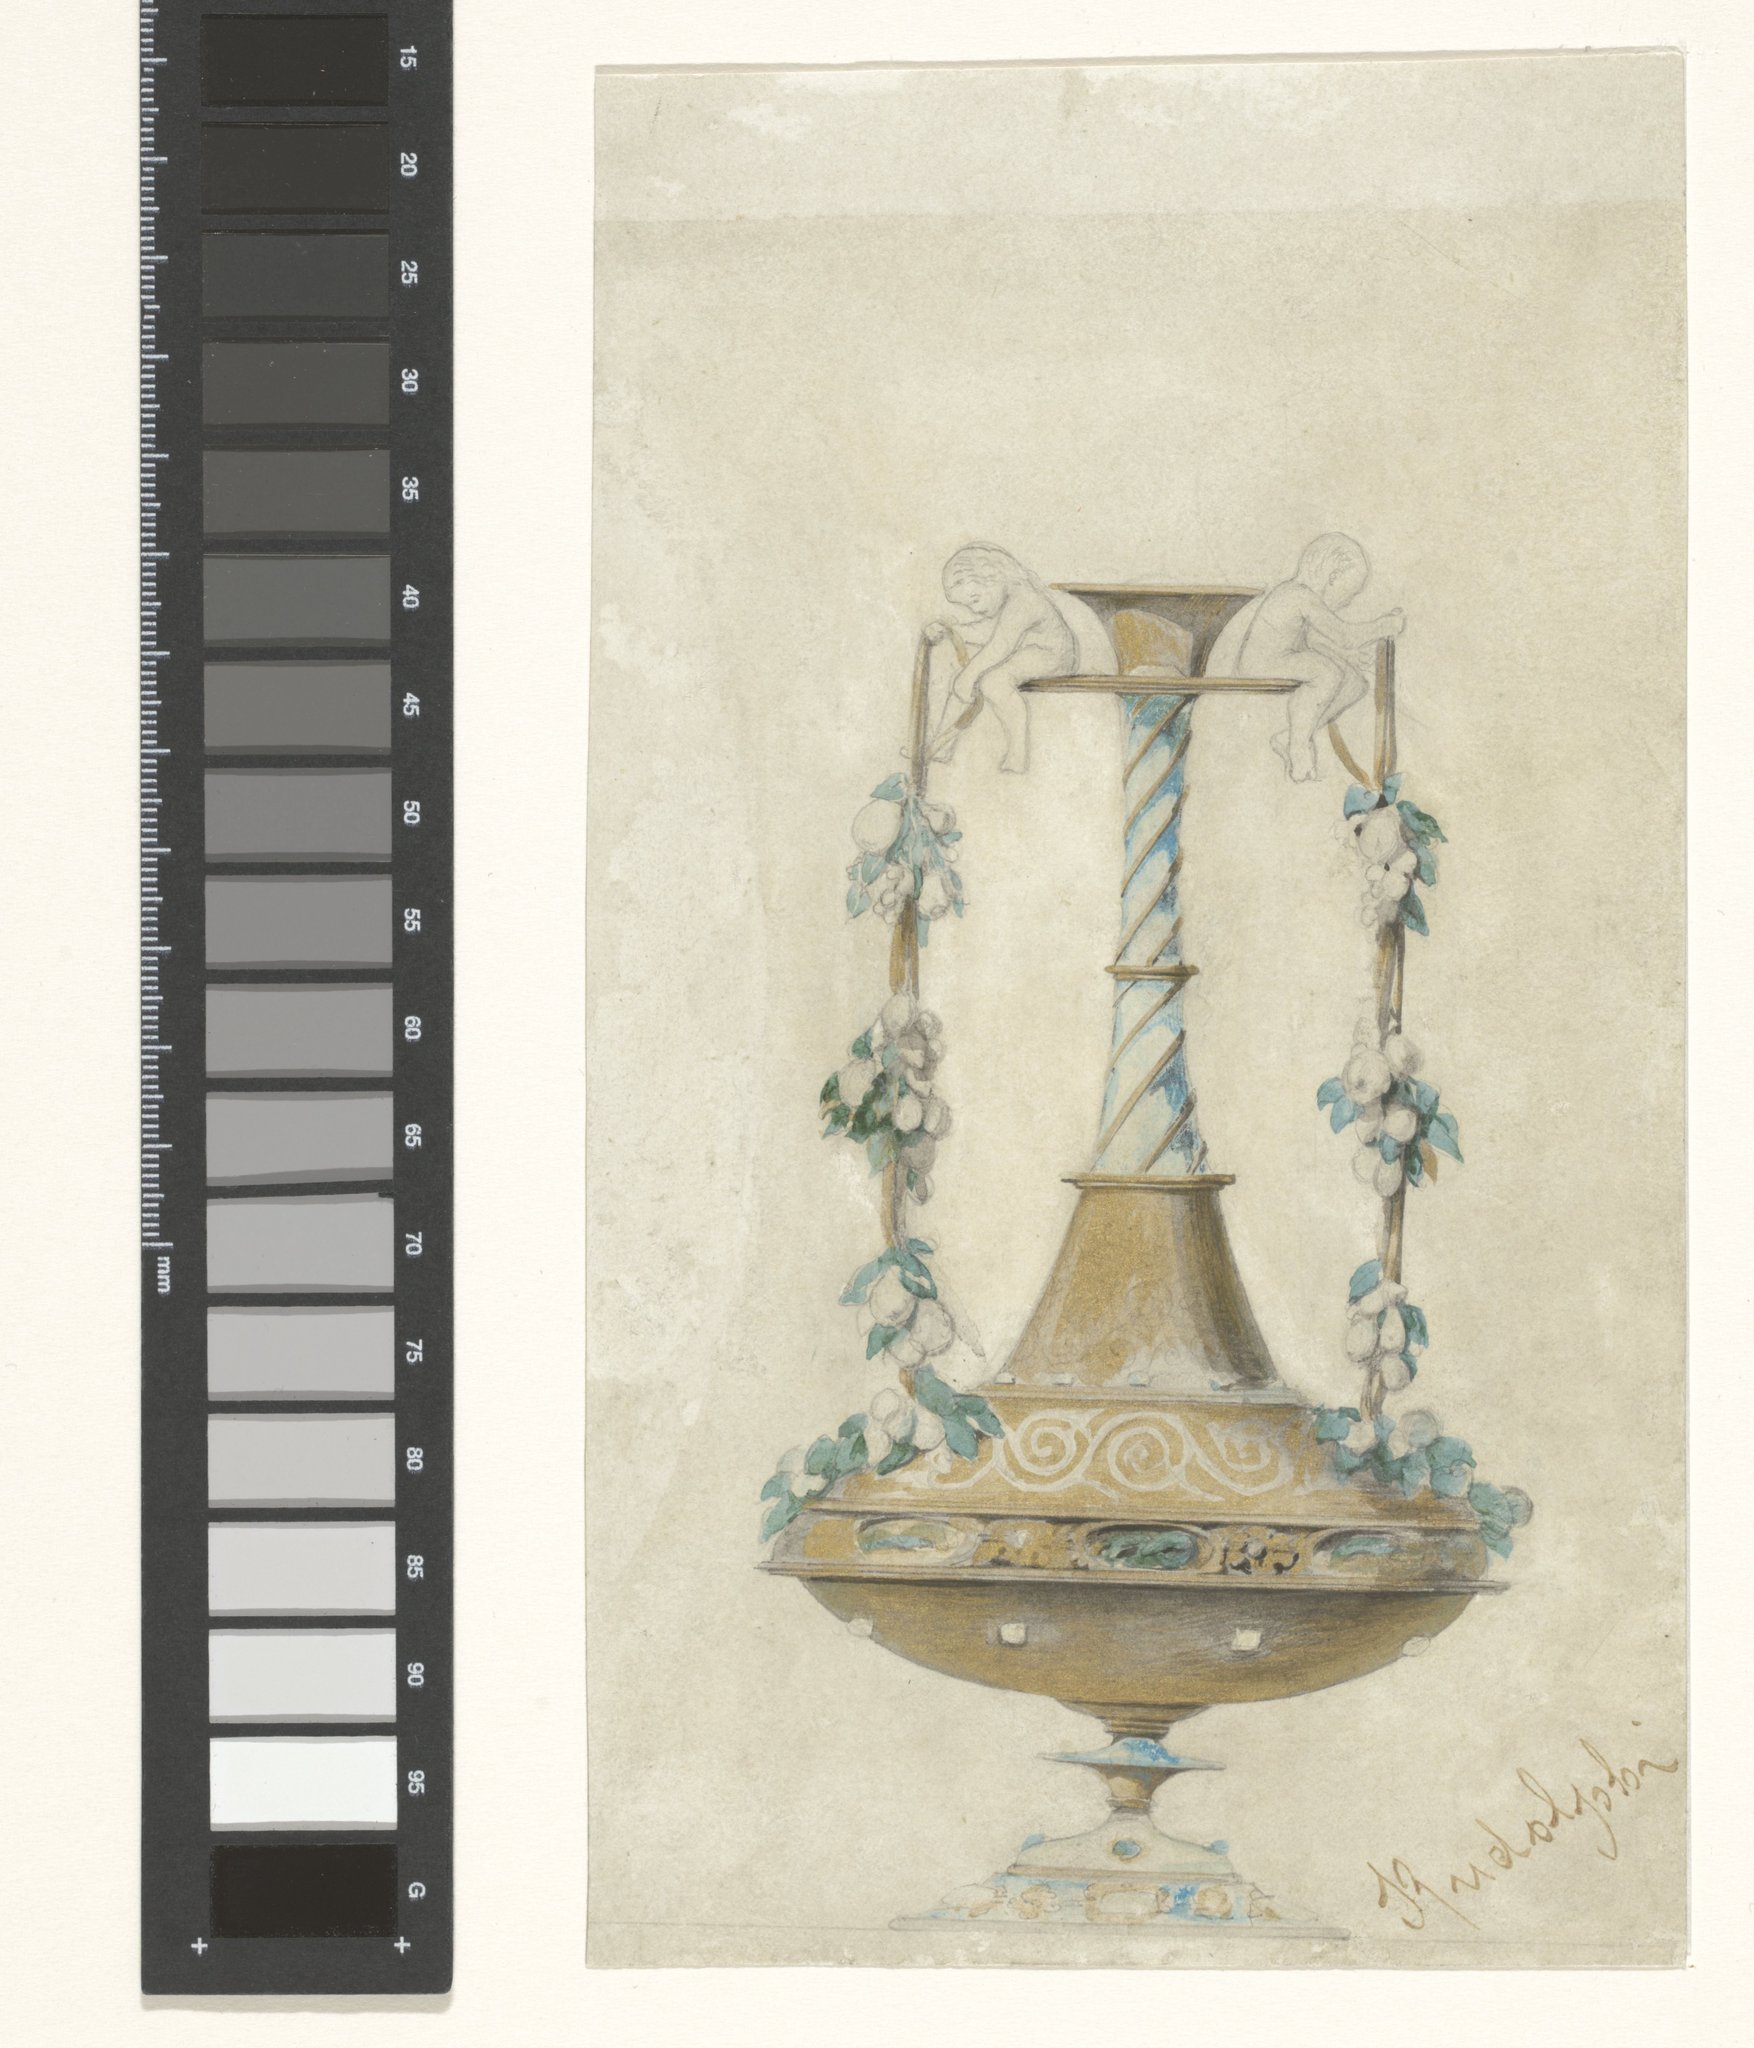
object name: design drawing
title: Ontwerp voor een vaas met oren in de vorm van jongetjes die linten met vruchtentrossen vasthouden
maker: frédéric-jules rudolphi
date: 1850-1870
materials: graphite, paper, watercolor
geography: paris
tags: containers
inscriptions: signature: ‘Rudolphi’